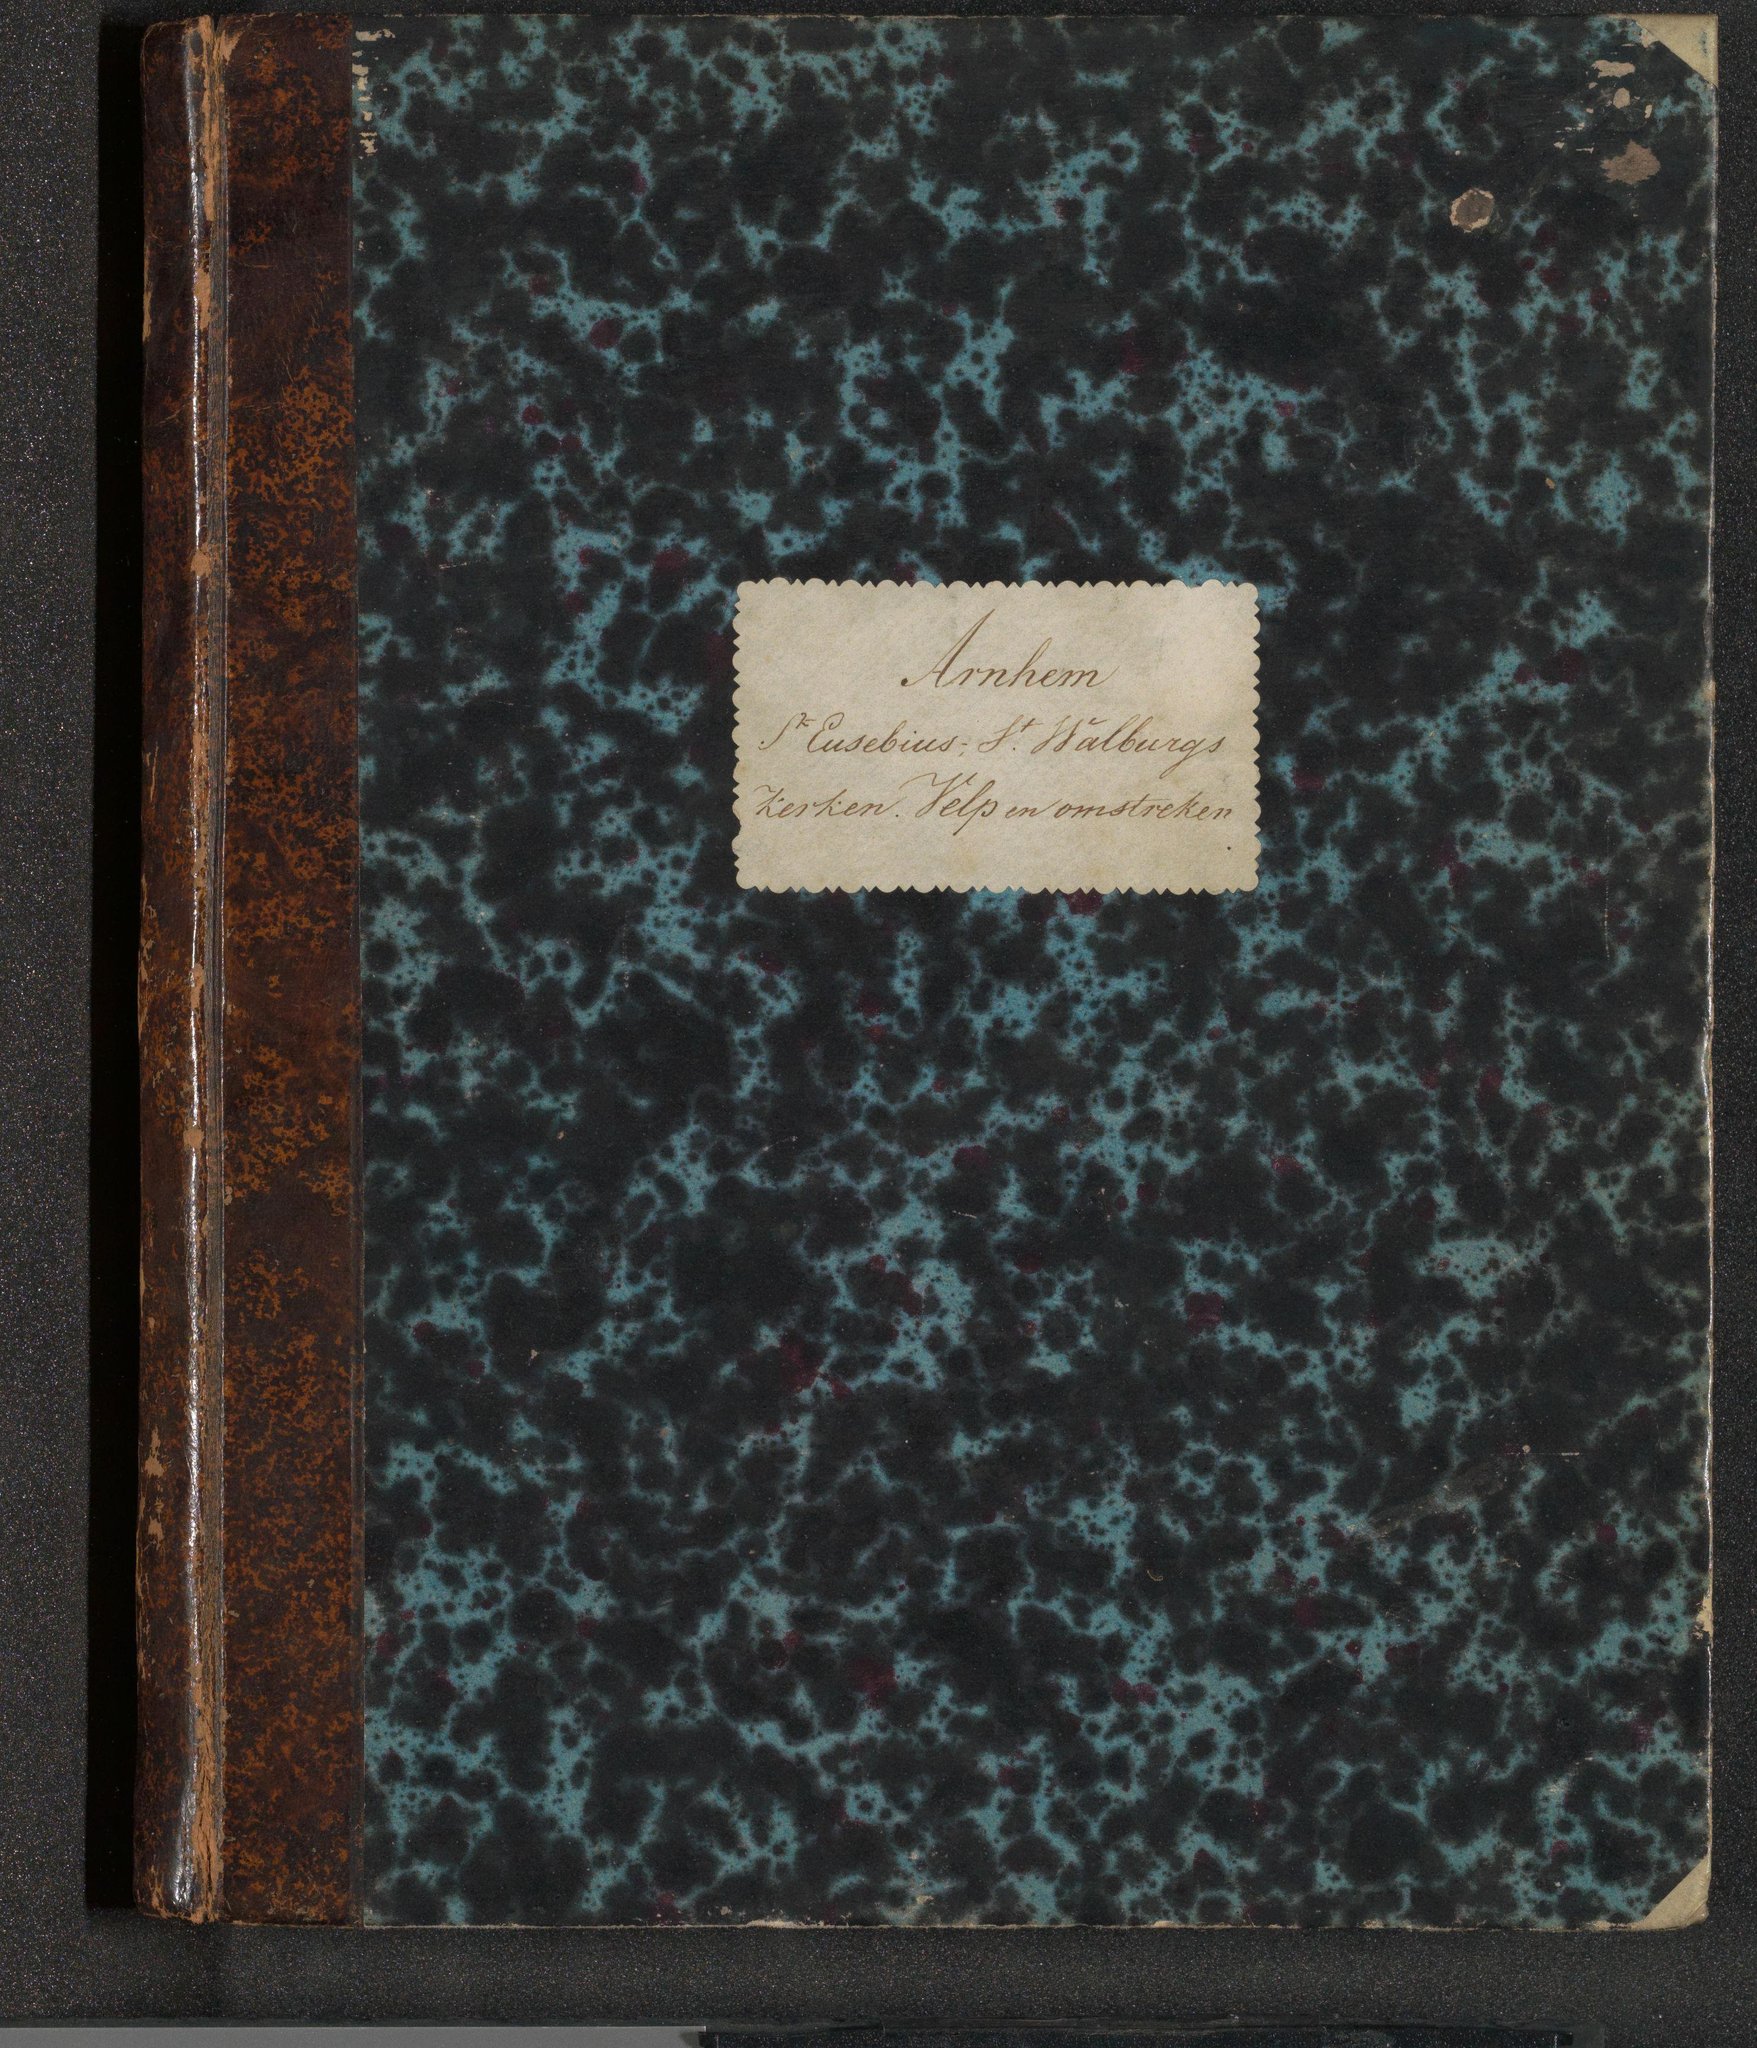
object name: album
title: Schetsboek met 94 bladen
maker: gaspard louis françois van kinschot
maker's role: print maker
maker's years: 1811-1861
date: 1821-1861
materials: cardboard, ink, leather, paper, pencil, watercolor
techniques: brush, pen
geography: arnhem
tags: interior of church, piece of sculpture, reproduction of a piece of sculpture, other memorial structures, grave-building, monumental tomb, armorial bearing, heraldry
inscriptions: number: ‘B984’, annotation: ‘Grafschriften en monumenten/ in de Groote of Eusebius kerk/ te Arnhem’, label: ‘Arnhem/ St Eusebius: S Walburgs/ kerken Velp en omstreken’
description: De volgende bladen uit het schetsboek zijn blanco: 1-3, 5(V), 7(V), 8(V), 9(V), 10(V), 11(V), 12(V), 13(V), 14(V), 15(V), 16(V), 17(V), 18(V), 21(V), 23(V), 24(V), 26(V), 27(V), 28(V), 29(V), 30(V), 31(V), 35(V), 38(V), 39(V), 40(V), 41(V), 42(V), 43(V), 44(V), 45(V), 46(V), 47(V), 48(V), 49(V), 50(V), 51(V), 53(V), 55(V), 57(V), 58(V), 59(V)-61, 64(V), 65(V), 66(V), 67(V), 69(V), 70(V), 71(V), 72(V), 73(V), 74(V), 75(V), 76(V), 77(V), 78(V), 79(V), 80(V), 81(V), 82(V), 83(V), 84(V), 85(V), 87(V), 88(V), 89(V).